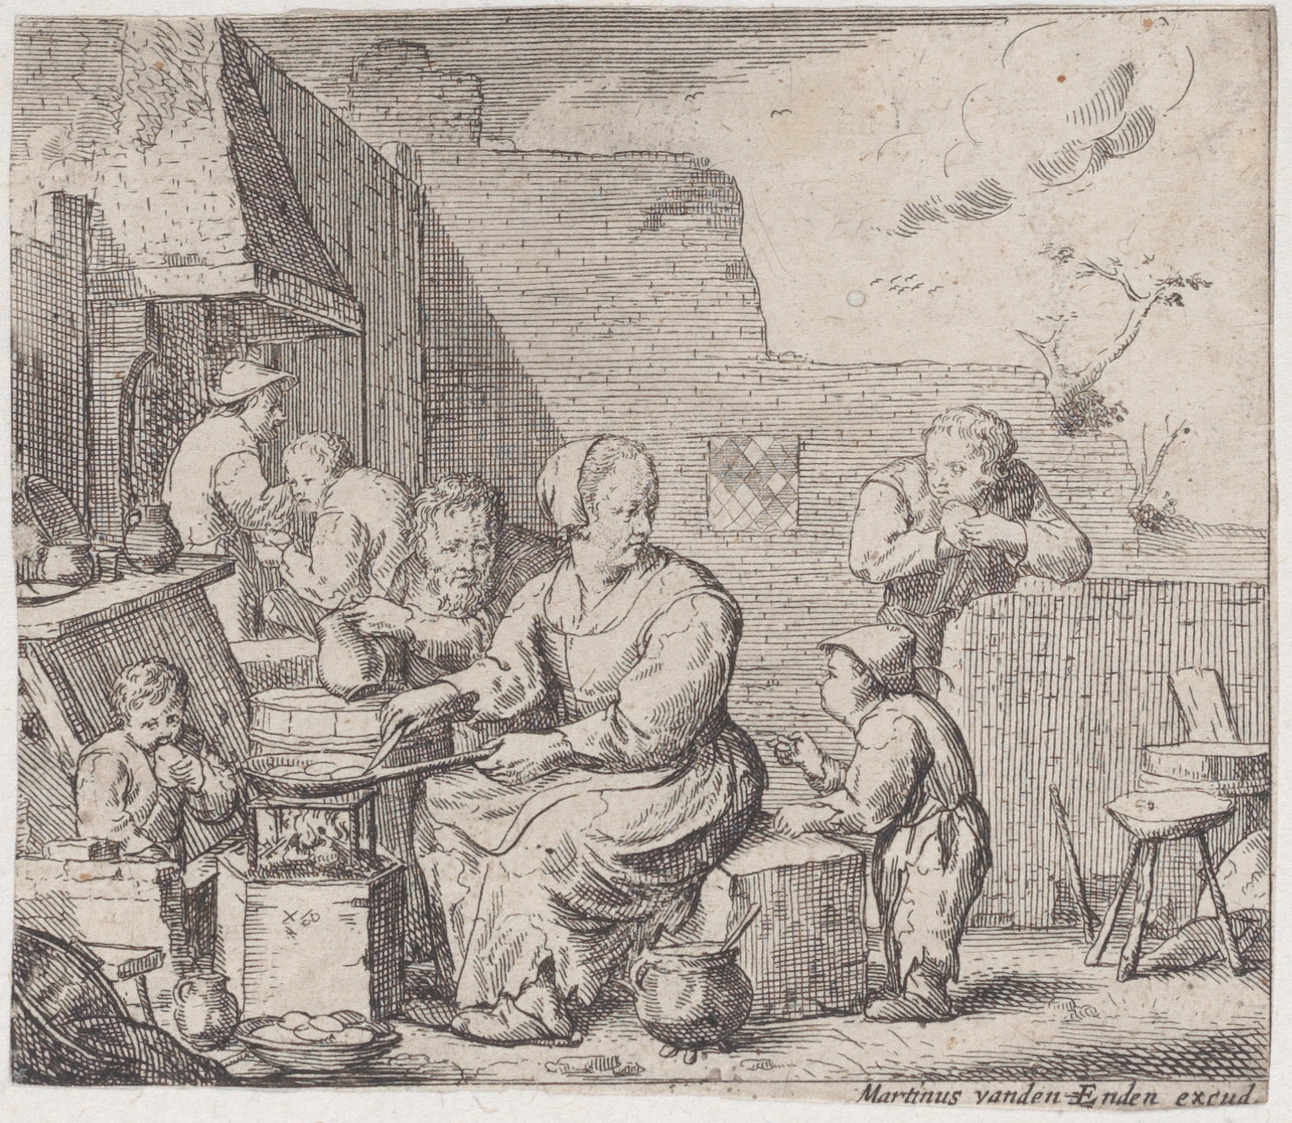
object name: print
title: Peasant woman, seated, and cooking, with three children and a man around her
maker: jacques dassonville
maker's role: artist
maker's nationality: french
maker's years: 1614-1675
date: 1640-1670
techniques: etching